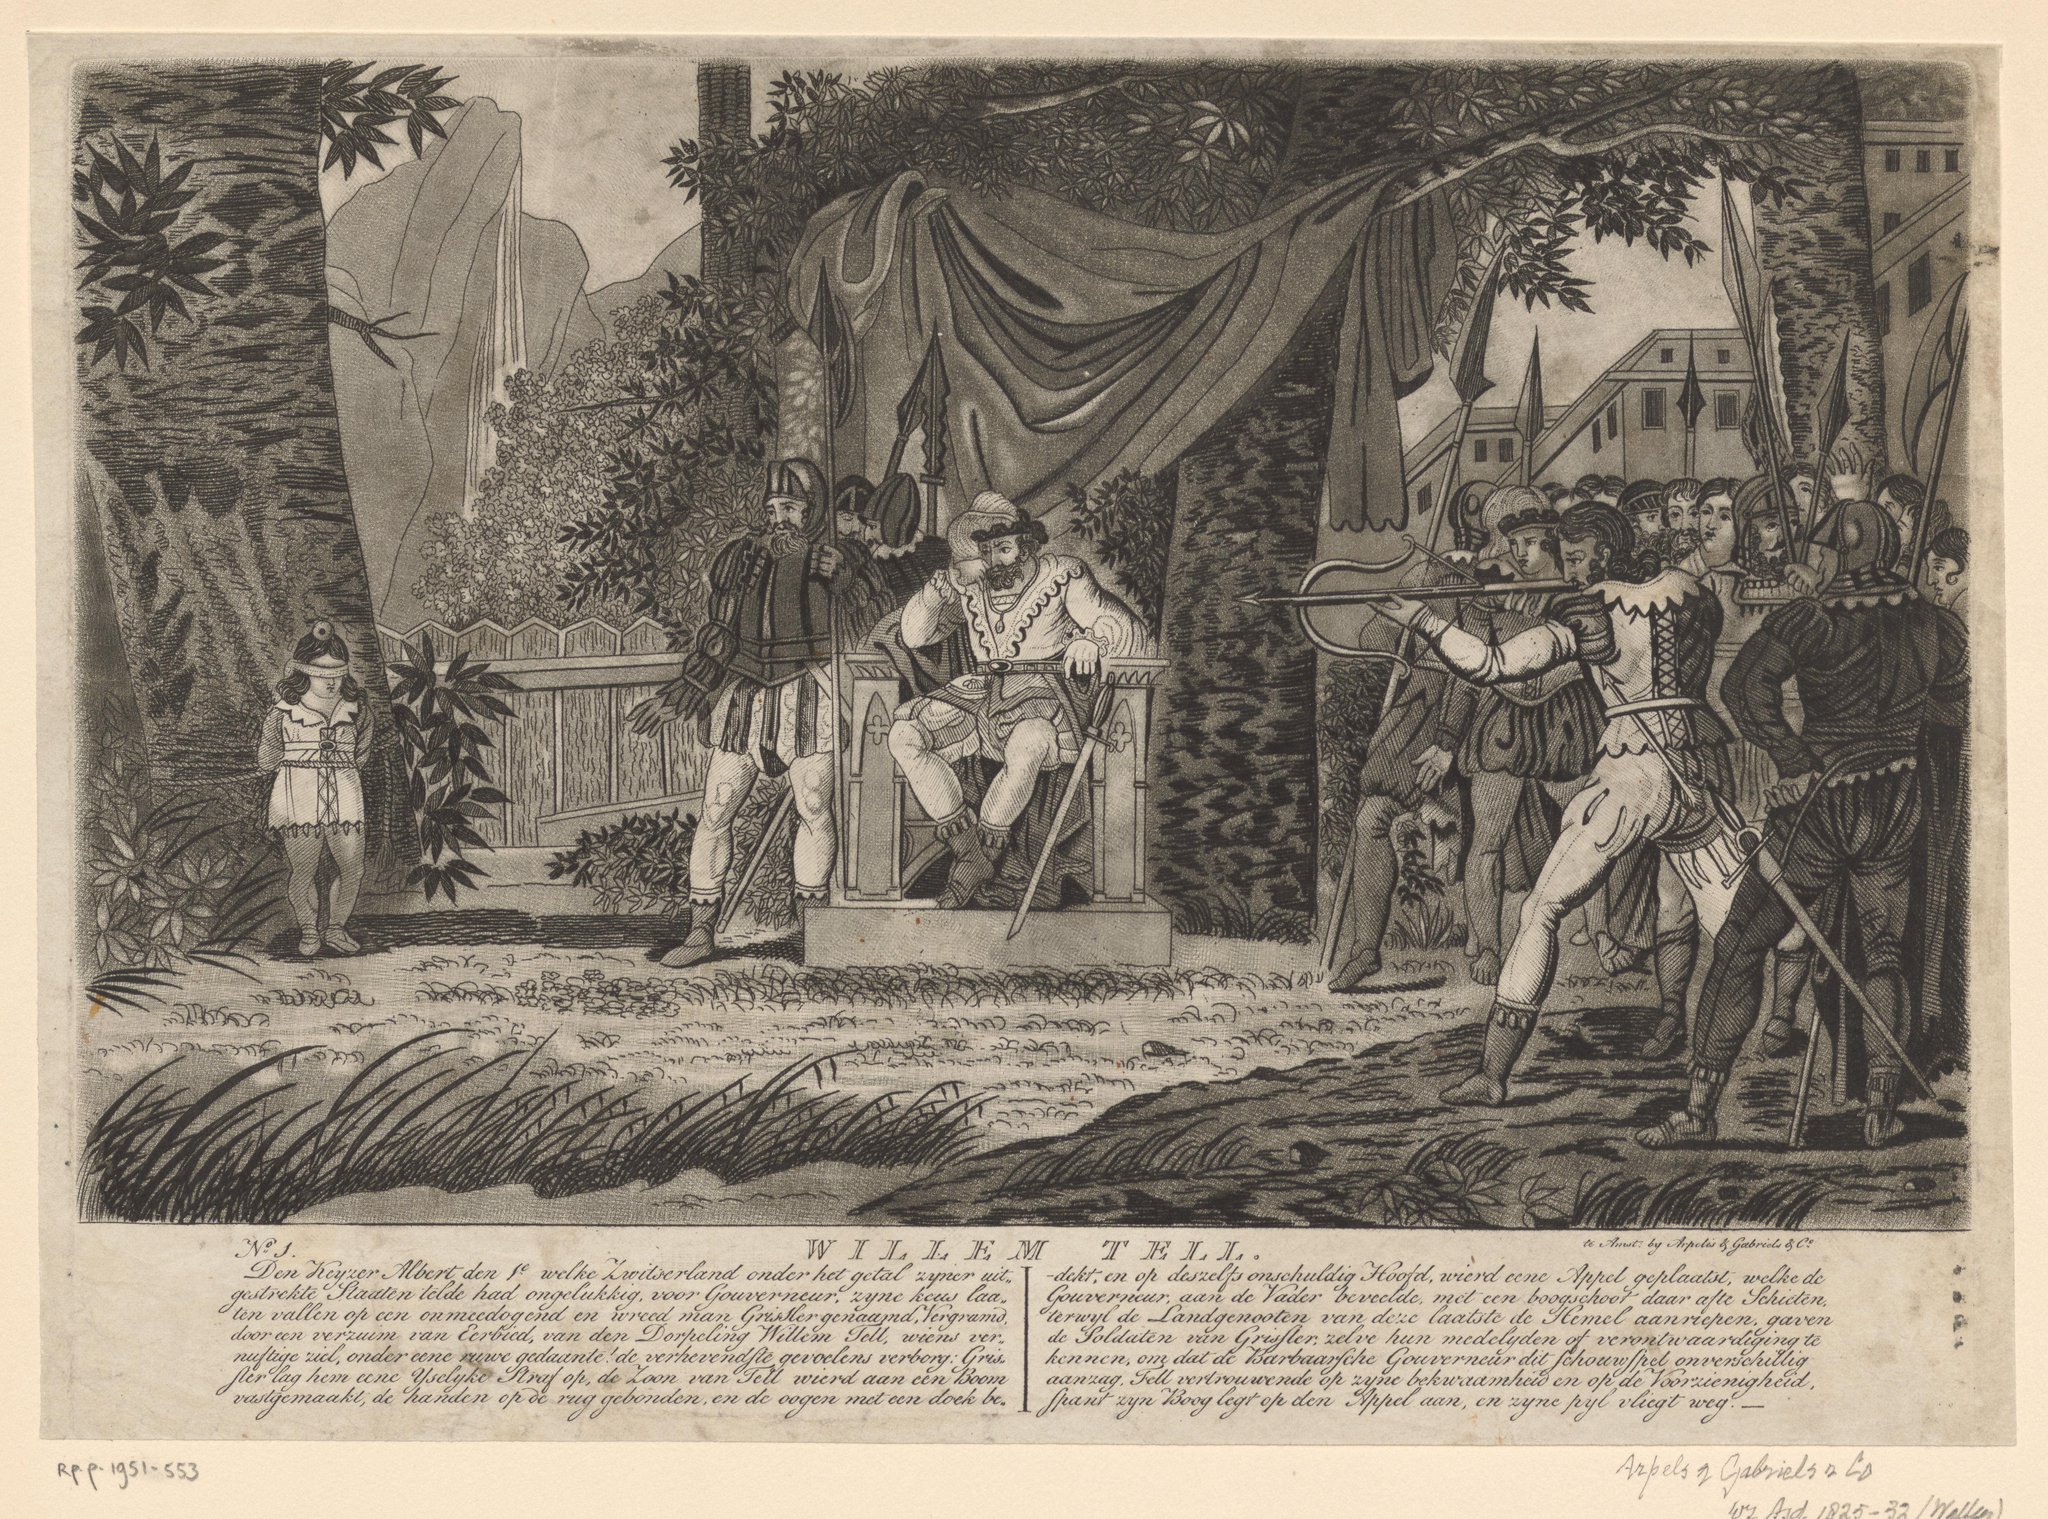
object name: print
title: Willem Tell schiet de appel van Walters hoofd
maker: Anonymous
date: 1800-1899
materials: paper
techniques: engraving, etching, roulette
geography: amsterdam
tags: william tell, archer's weapons: bow and arrow, throne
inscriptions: collector's mark: Lugt 2228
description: Onder de voorstelling een zevenregelig onderschrift.